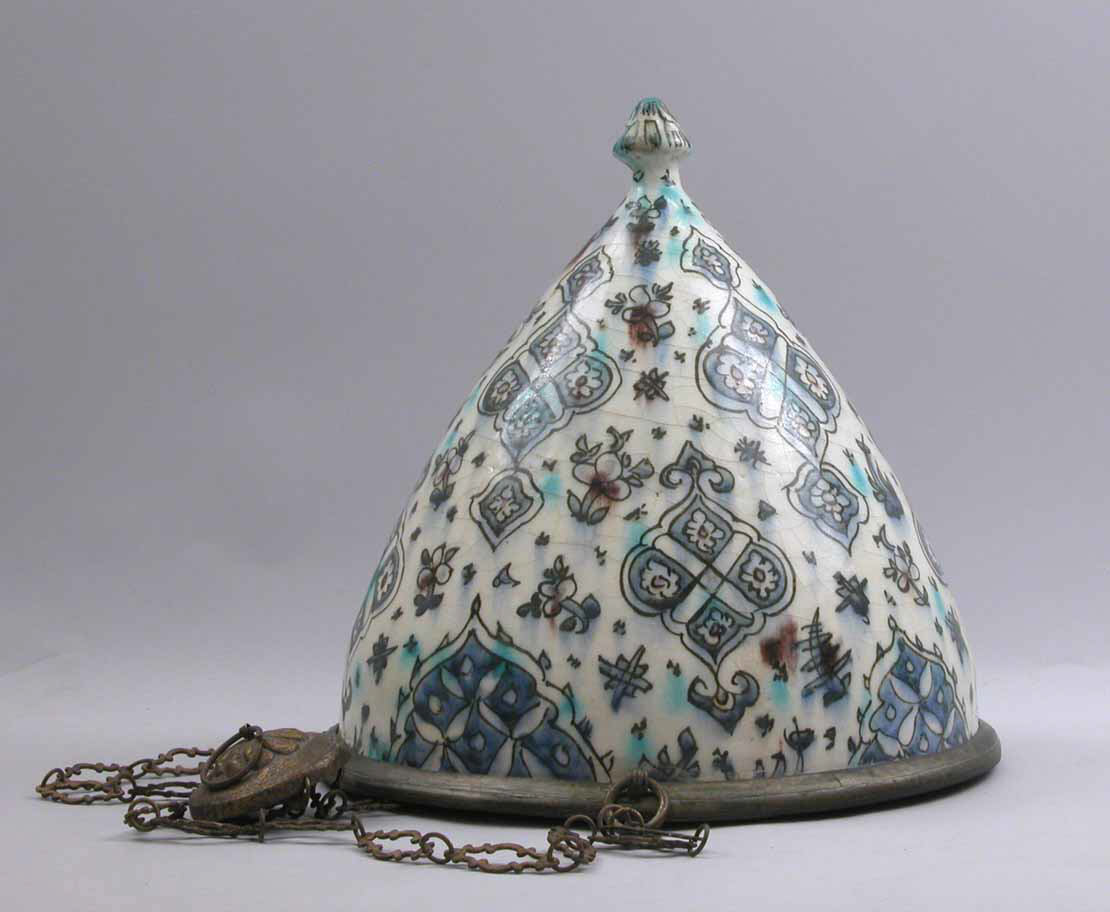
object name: mosque lamp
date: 1601-1700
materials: glaze, stonepaste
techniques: painting, polychrome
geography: syria